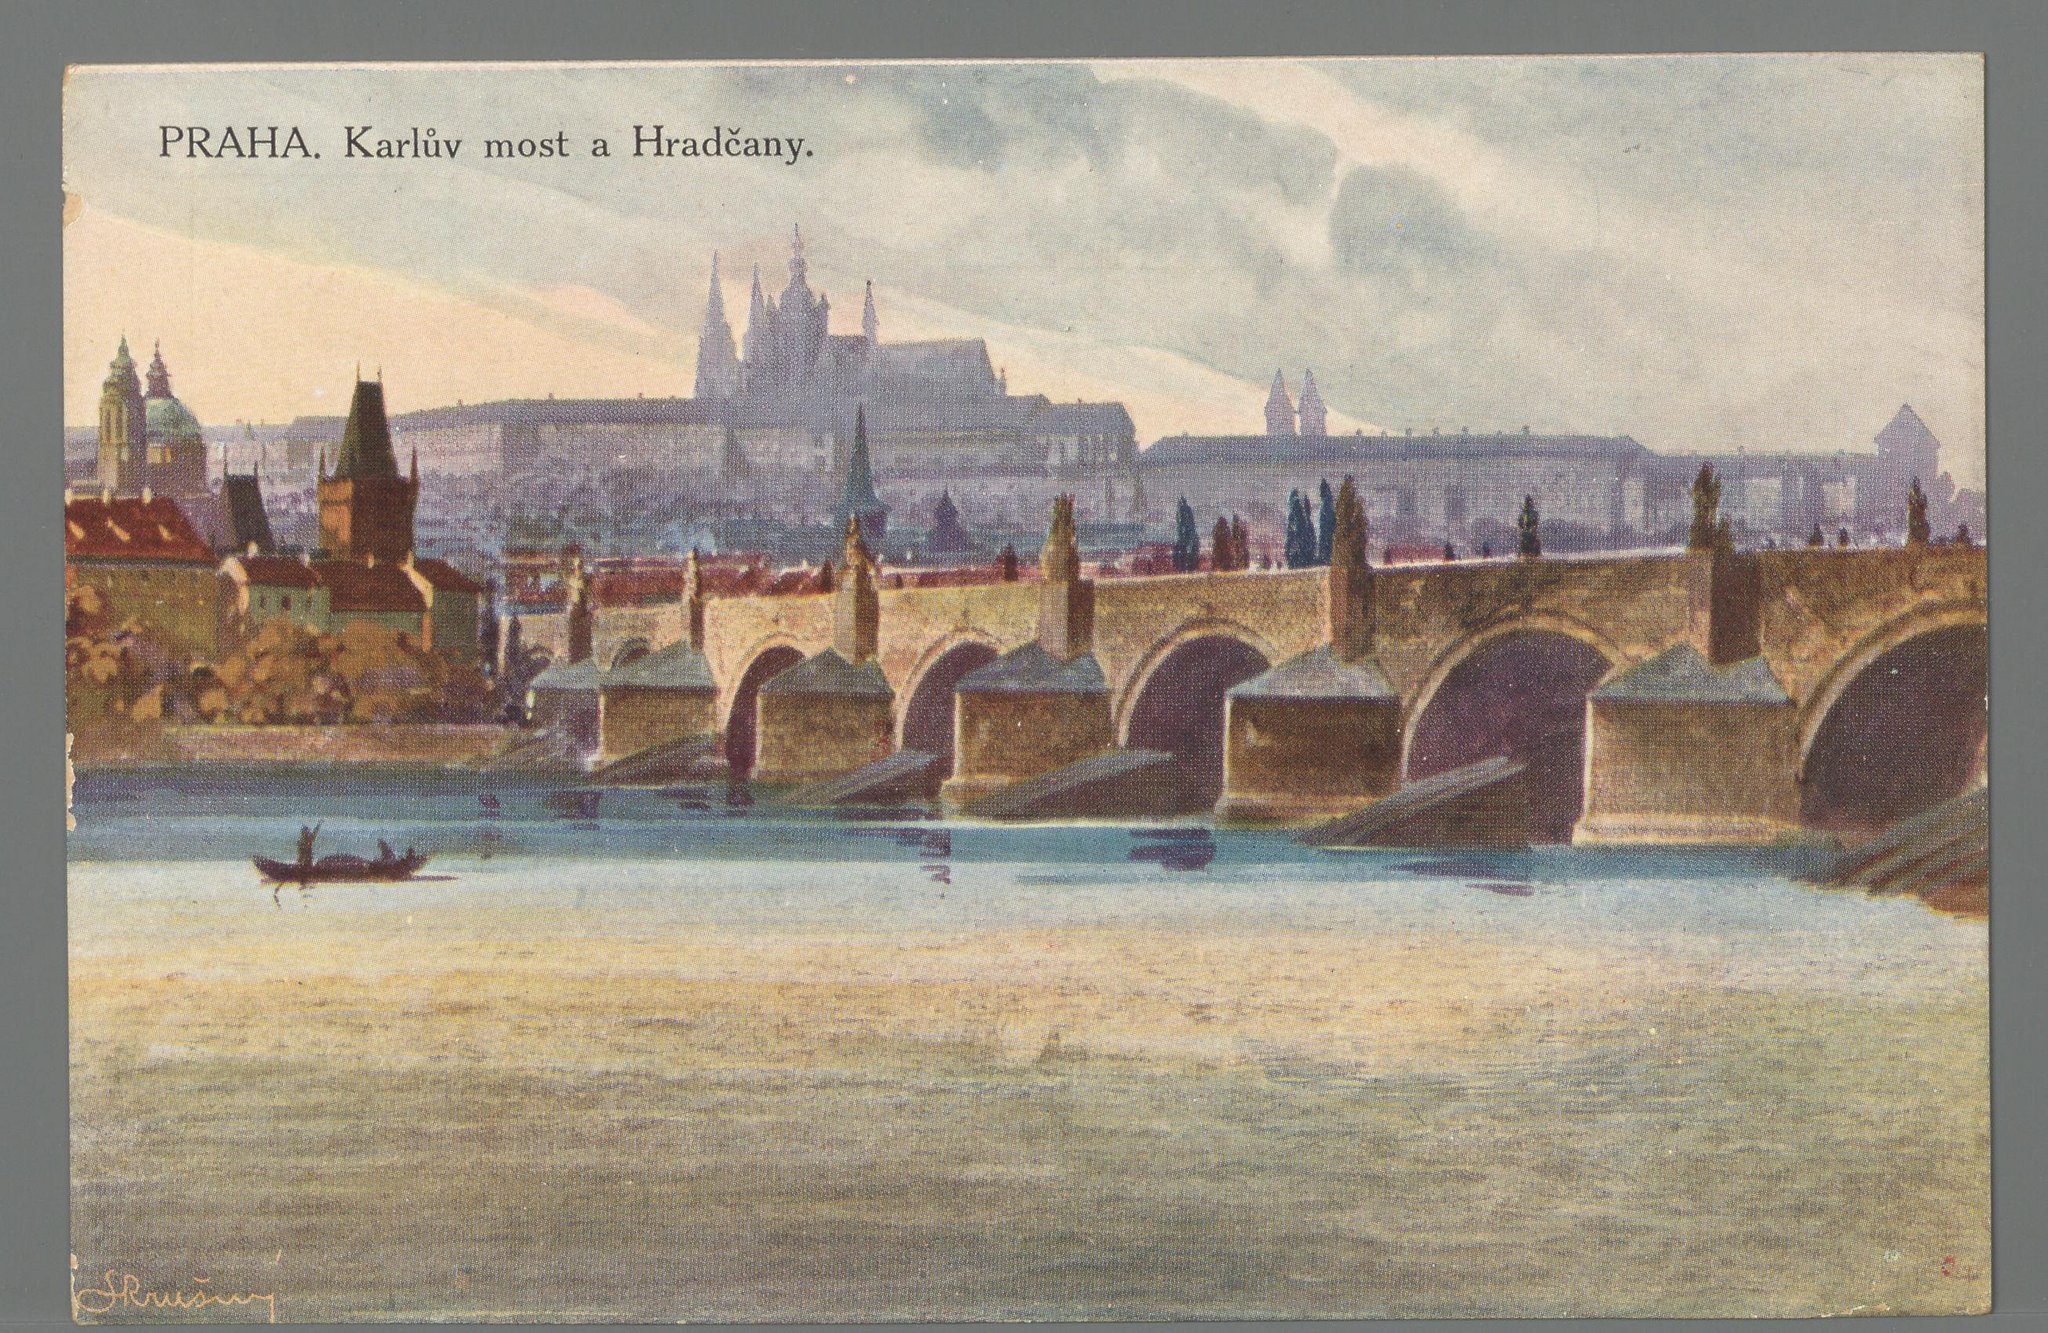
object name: reproduction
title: Praha. Karluv most a Hradčany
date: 1906-1930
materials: cardboard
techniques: color autotype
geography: prague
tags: castle, church (exterior), canals, waters (in city), bridge in city across river, canal, etc.